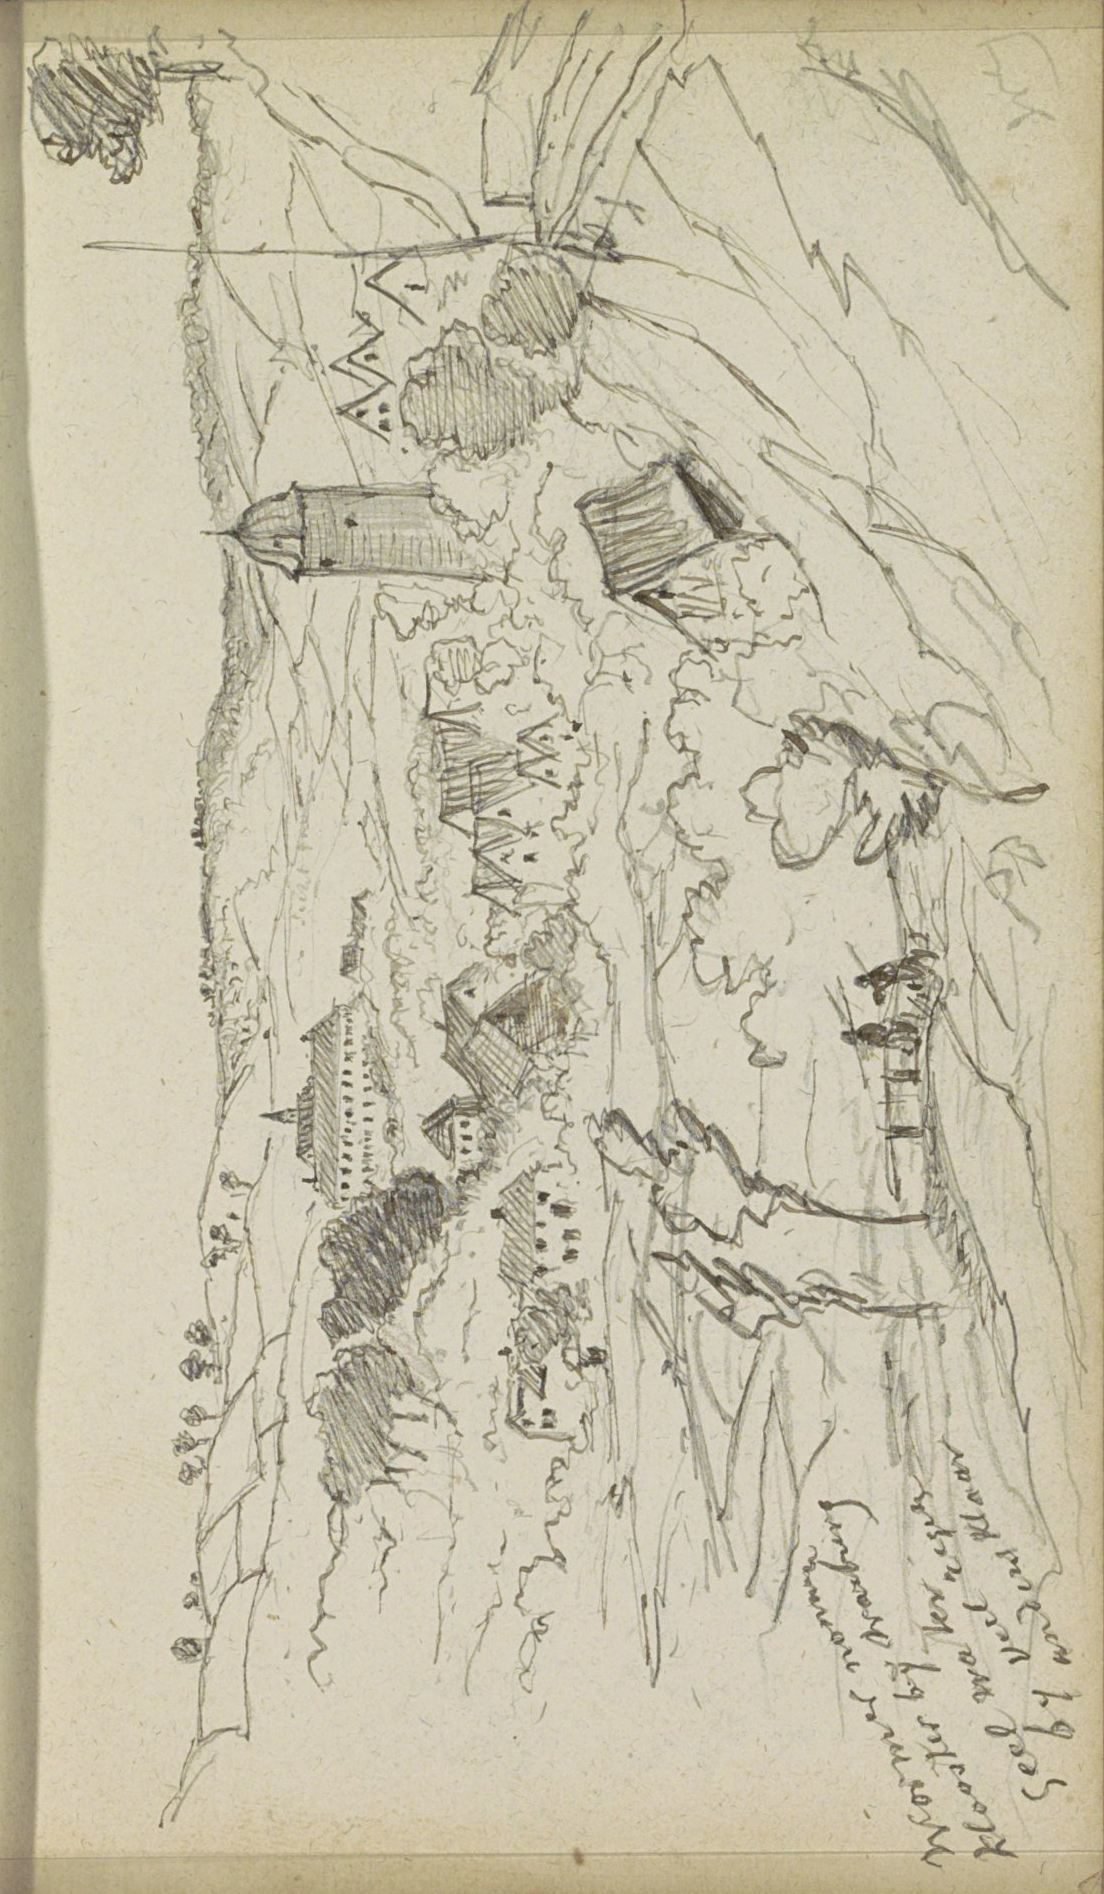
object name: sketchbook leaf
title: Gezicht op het nonnenklooster bij Warburg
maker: johannes tavenraat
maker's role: draughtsman, painter, print maker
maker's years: 1809-1881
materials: ink, paper, pencil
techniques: pen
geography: warburg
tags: city-view, and landscape with man-made constructions, abbey, monastery, convent ~ roman catholic church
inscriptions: annotation: ‘Wormer nonnen/ klooster bij Warburg/ geel water/ bij veel regen/ anders klaar’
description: Blad 10 recto uit een schetsboek met 88 bladen.